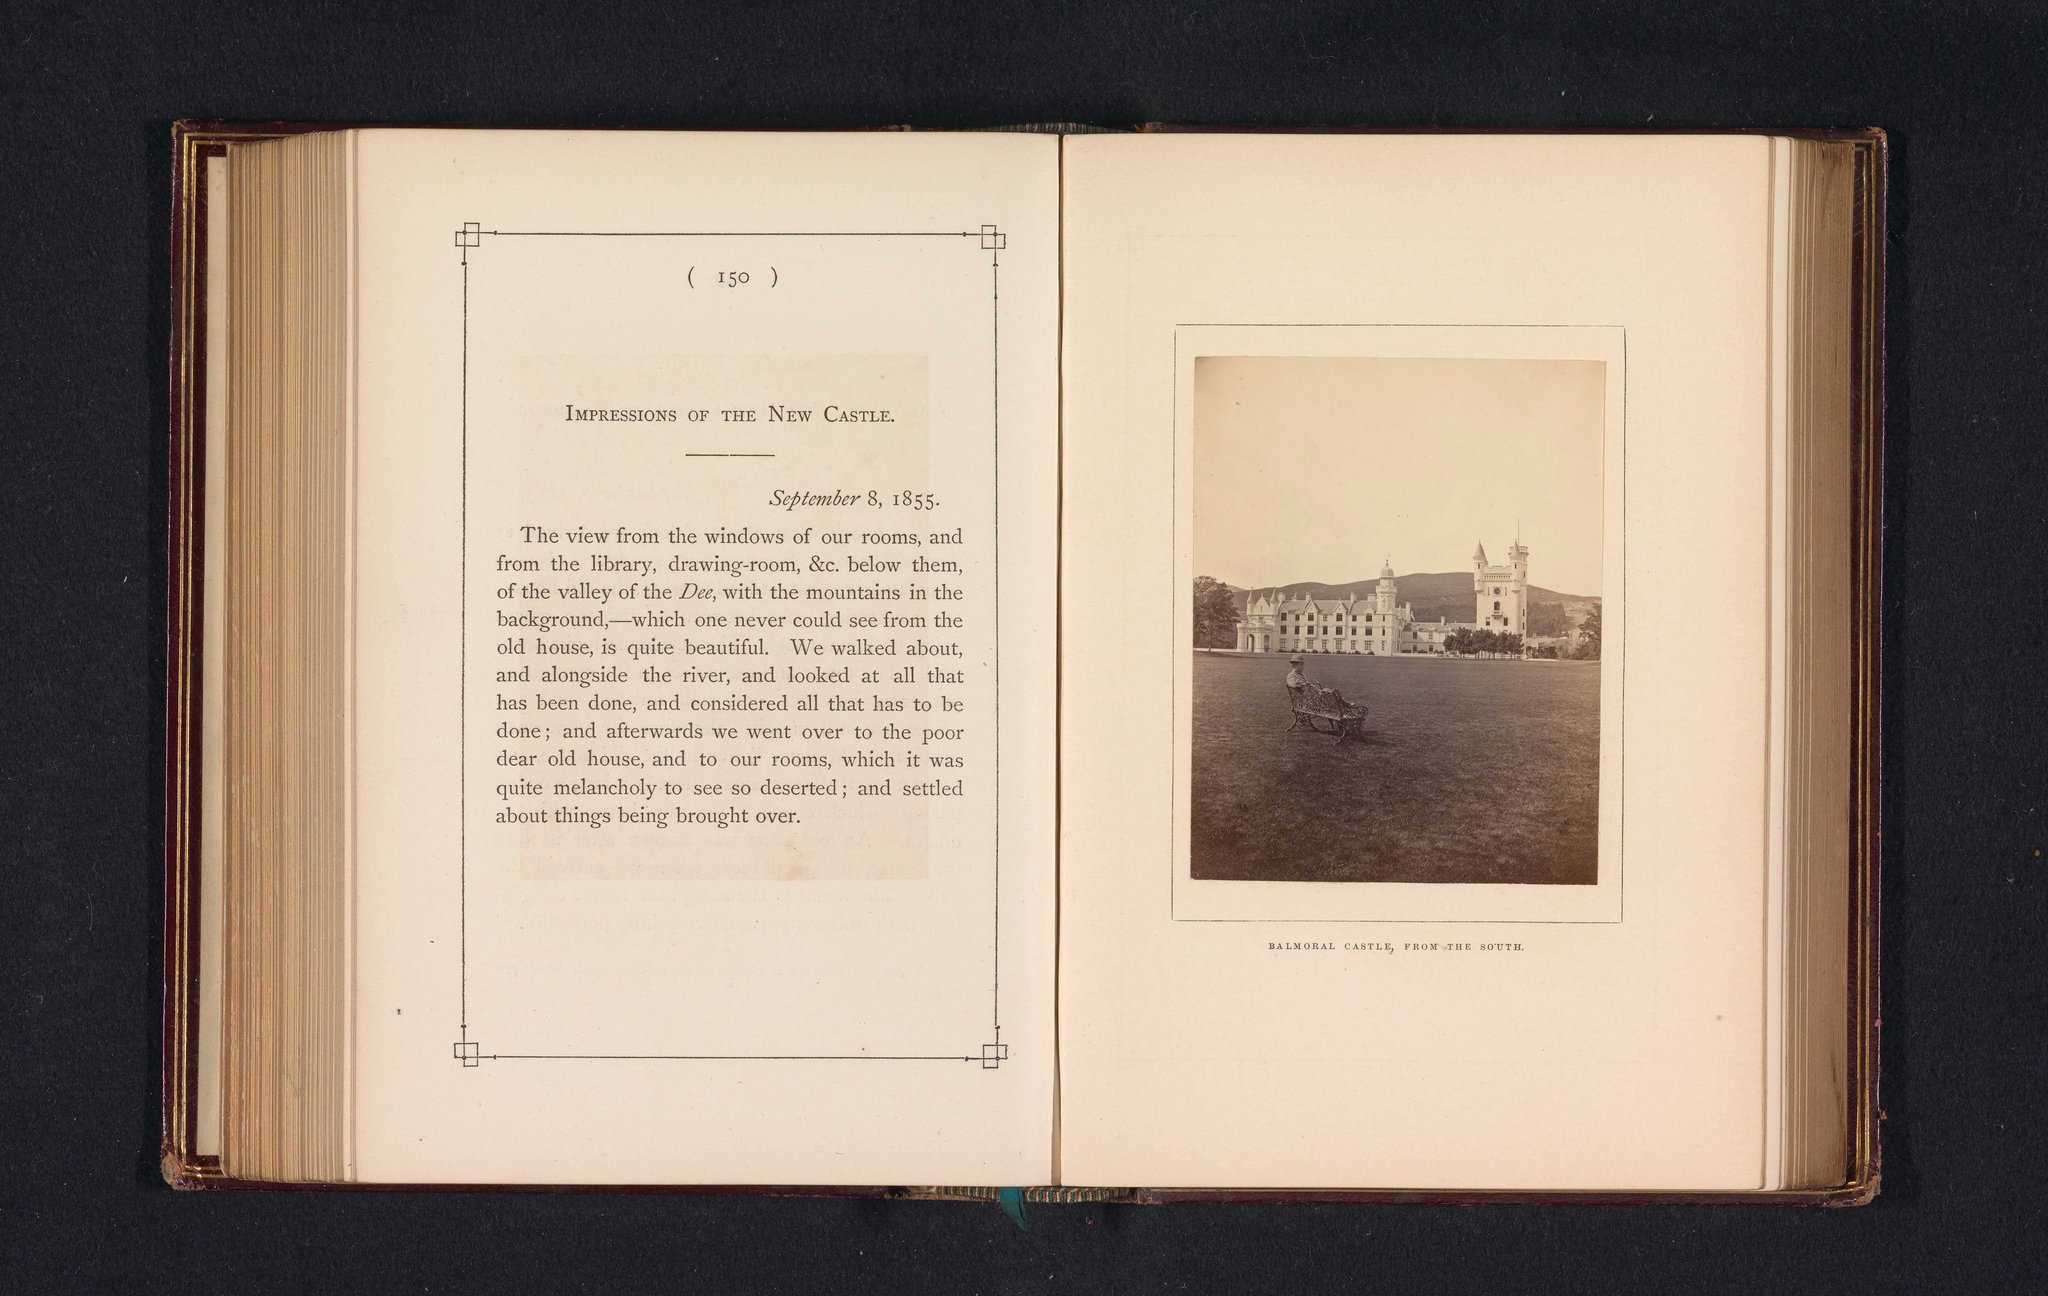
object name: photograph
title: Balmoral Castle, from the south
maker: george washington wilson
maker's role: publisher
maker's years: 1823-1893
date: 1858-1868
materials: photographic support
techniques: albumen print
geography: aberdeen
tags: castle